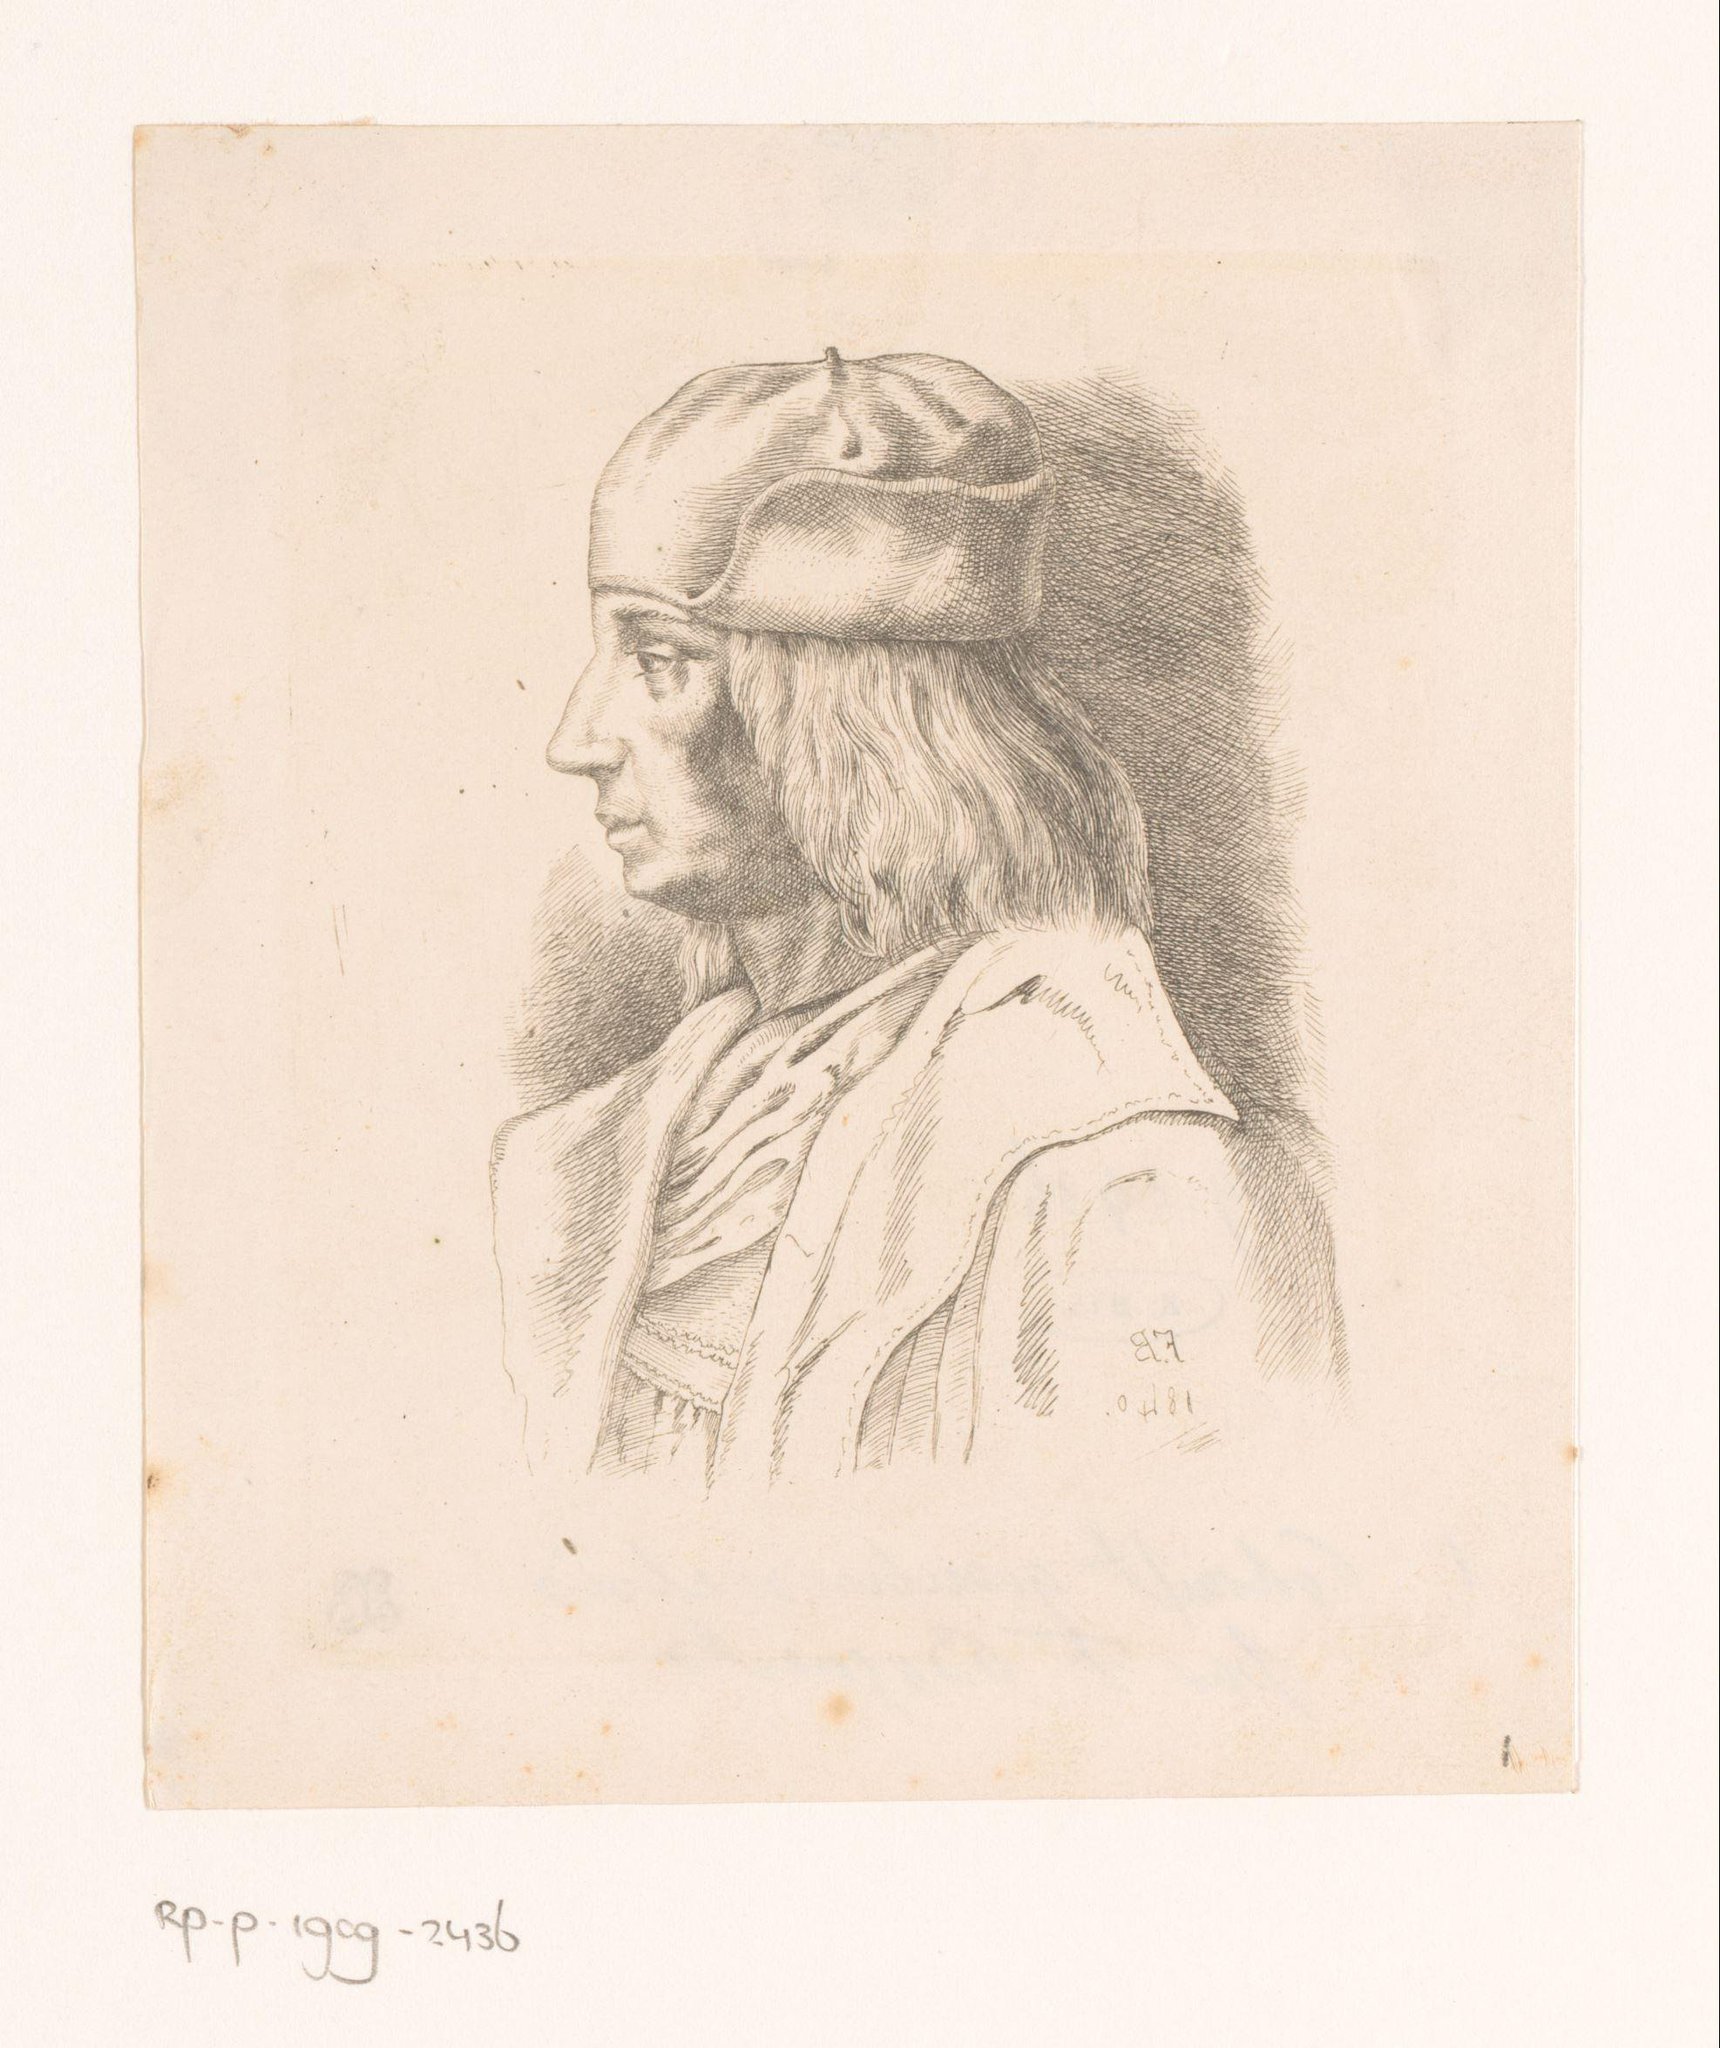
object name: print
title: Portret van Quinten Massijs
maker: felix bogaerts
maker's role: print maker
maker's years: 1805-1851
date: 1840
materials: paper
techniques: printmaking, etching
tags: louvain, antwerp, painter, draughtsman, quinten massijs (i), portrait, self-portrait of painter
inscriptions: collector's mark: Lugt 2228, collector's mark: Lugt 1485